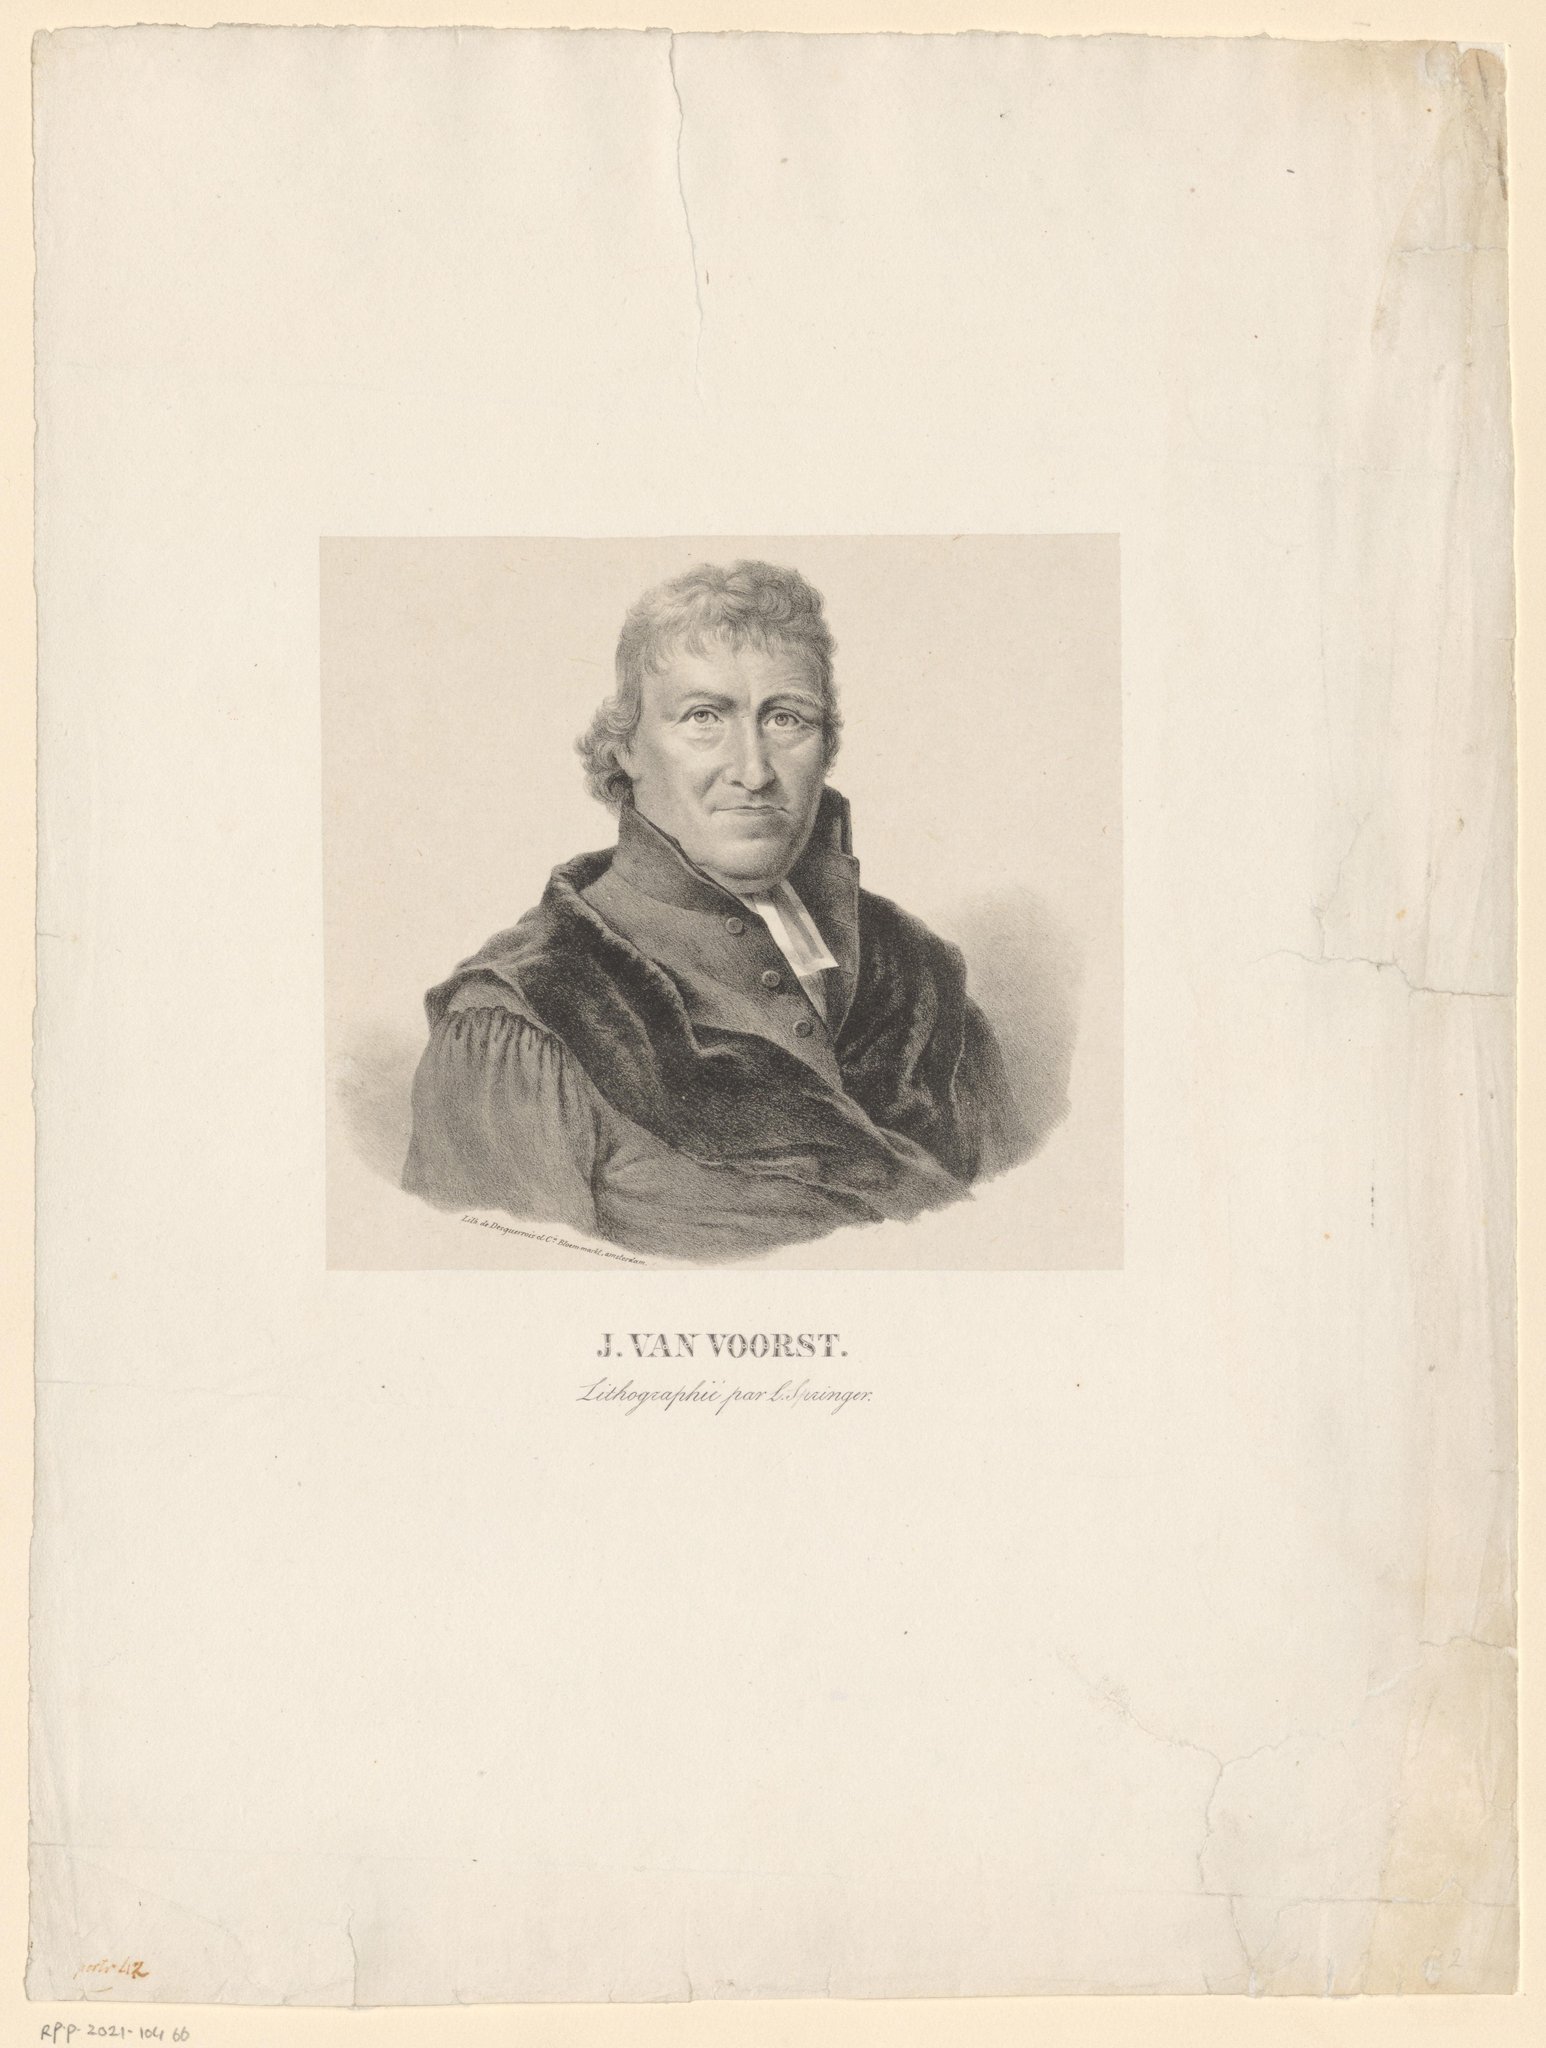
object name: print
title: J. van Voorst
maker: leendert springer (i)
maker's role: draughtsman, painter, print maker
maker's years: 1789-1871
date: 1827-1853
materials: paper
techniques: lithograph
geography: amsterdam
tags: leiden, adult man, historical persons